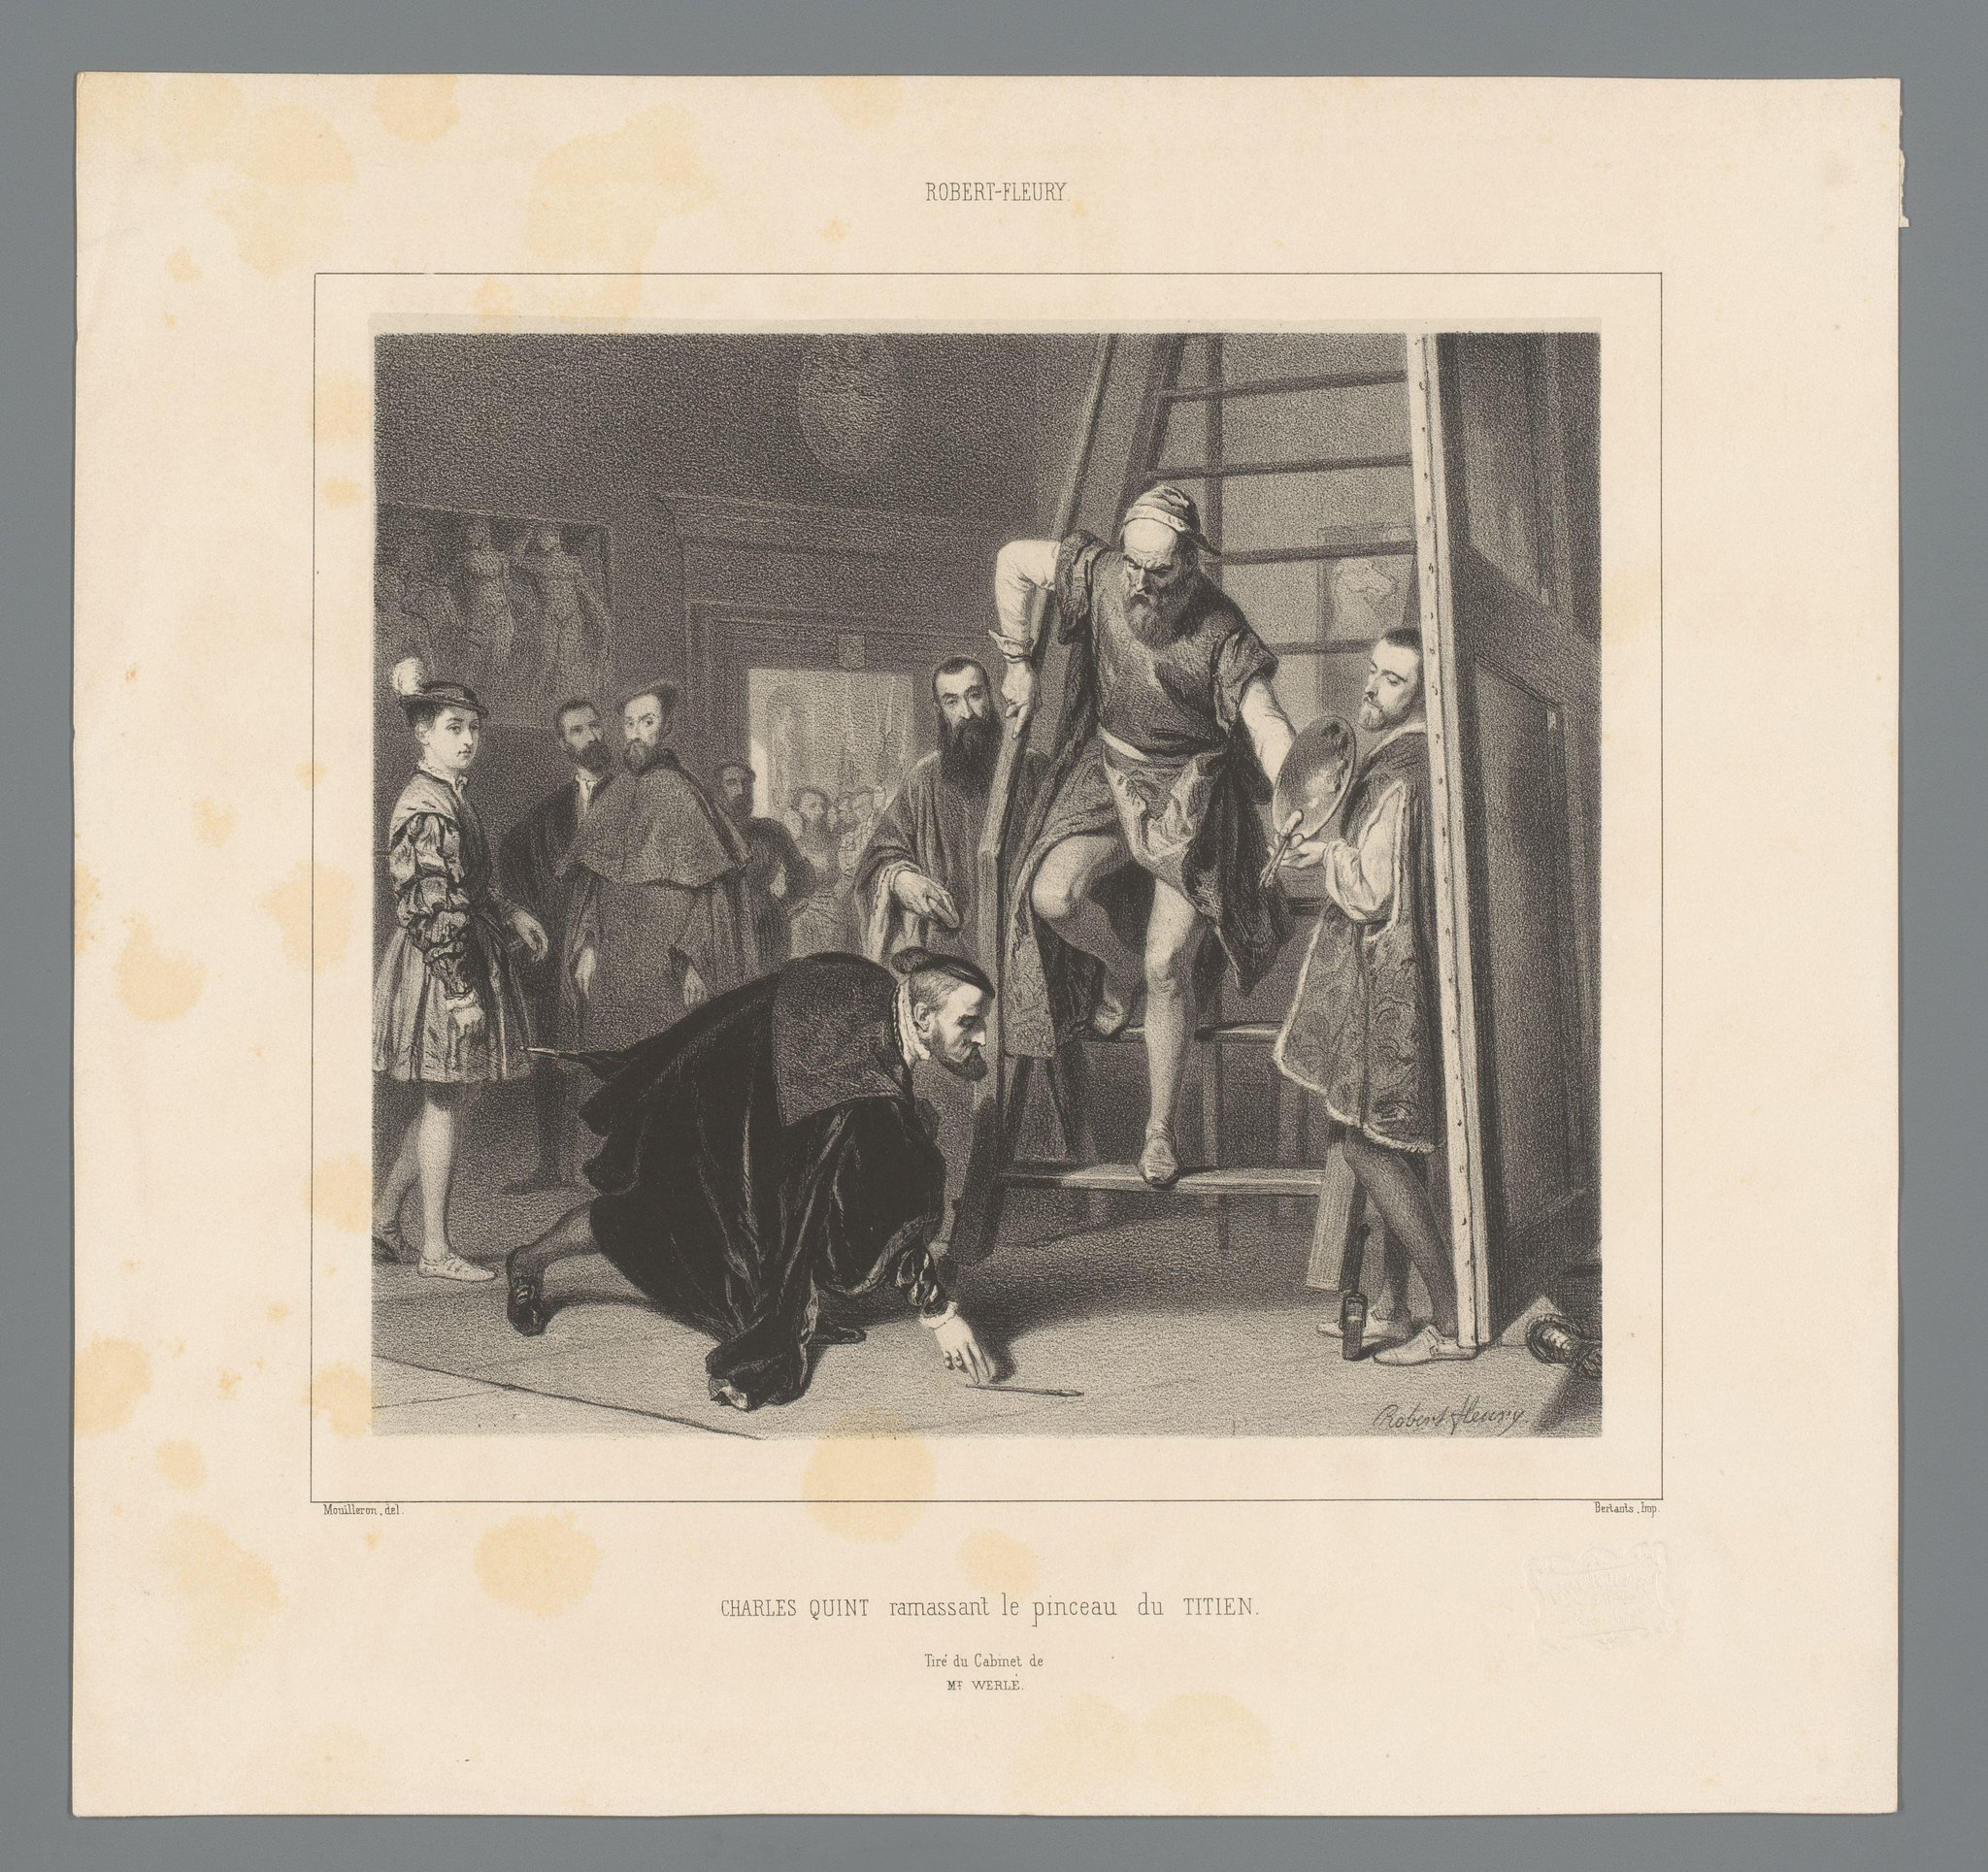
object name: print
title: Charles Quint ramassant le princeau du Titien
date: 1843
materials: paper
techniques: lithograph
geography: paris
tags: venice, painter, titiaan, ghent, charles v (holy roman emperor and king of spain), picture, painting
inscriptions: check stamp: Lugt 470b, collector's mark: Lugt 2228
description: Prent gebruikt in: Les Beaux-Arts. Illustration des arts et de la littérature. Deel 1. Parijs: Léon Curmer, 1843. En in: Ténint, Wilhelm. Album du Salon de 1843. Collection des principaux ouvrages exposés au Louvre (…). Parijs: Augustin Challamel, 1843.